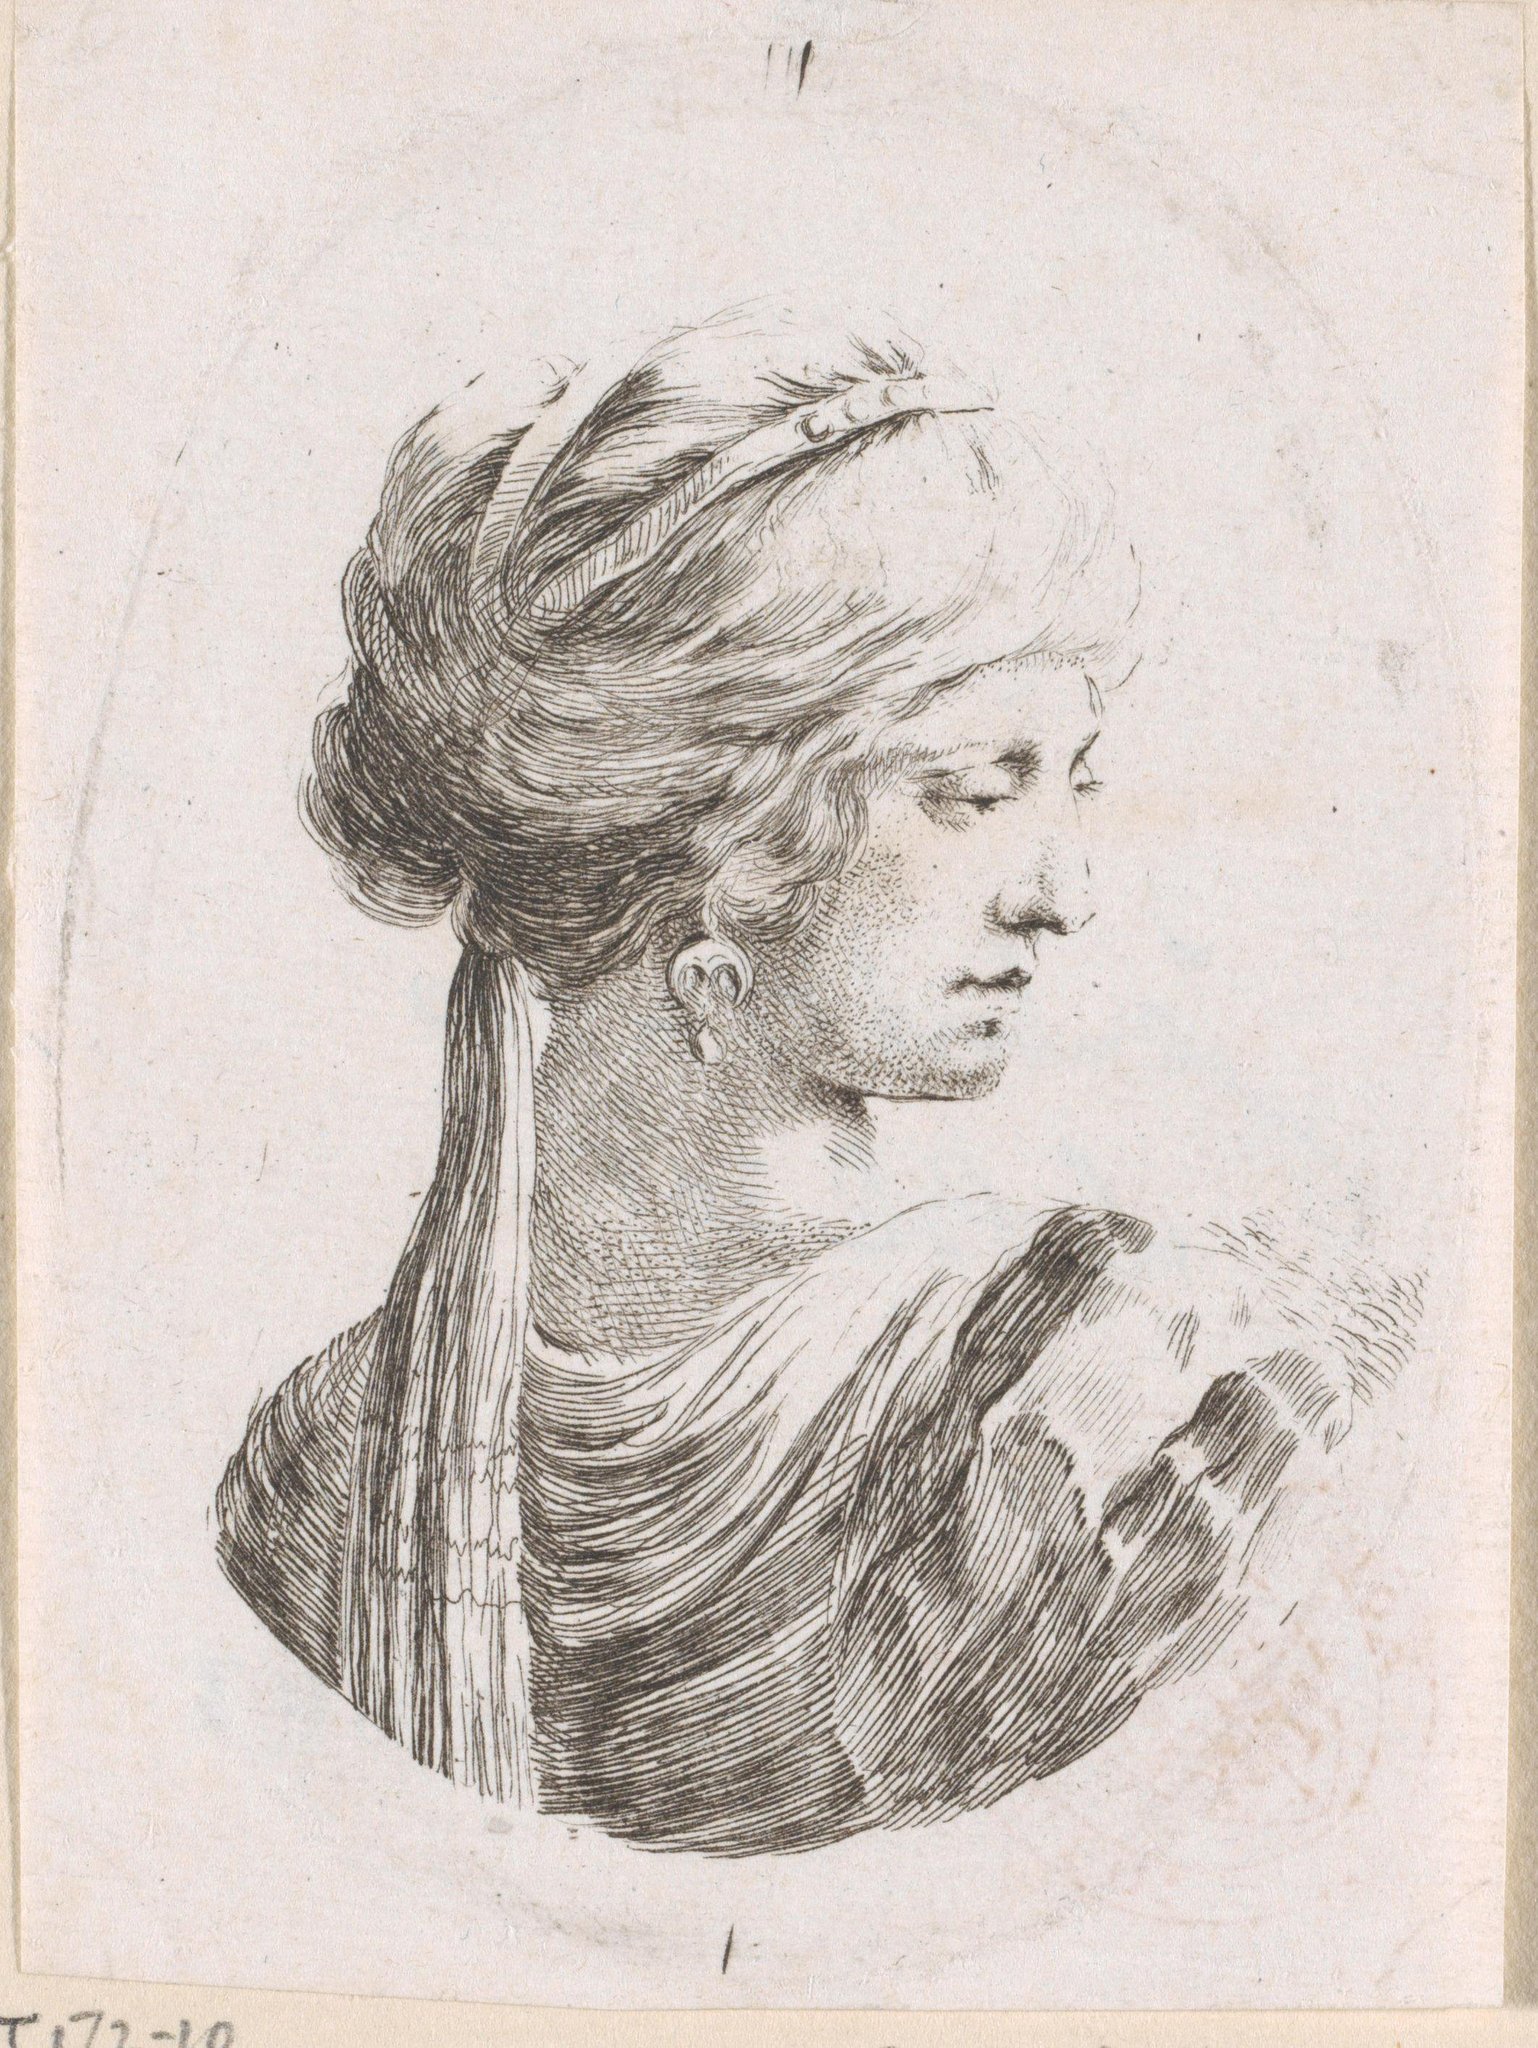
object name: print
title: Vrouw met tulband met afhangende voile, op de rug gezien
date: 1649-1650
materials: paper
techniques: etching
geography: paris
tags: adult woman, head-gear: turban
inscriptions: collector's mark: Lugt 240